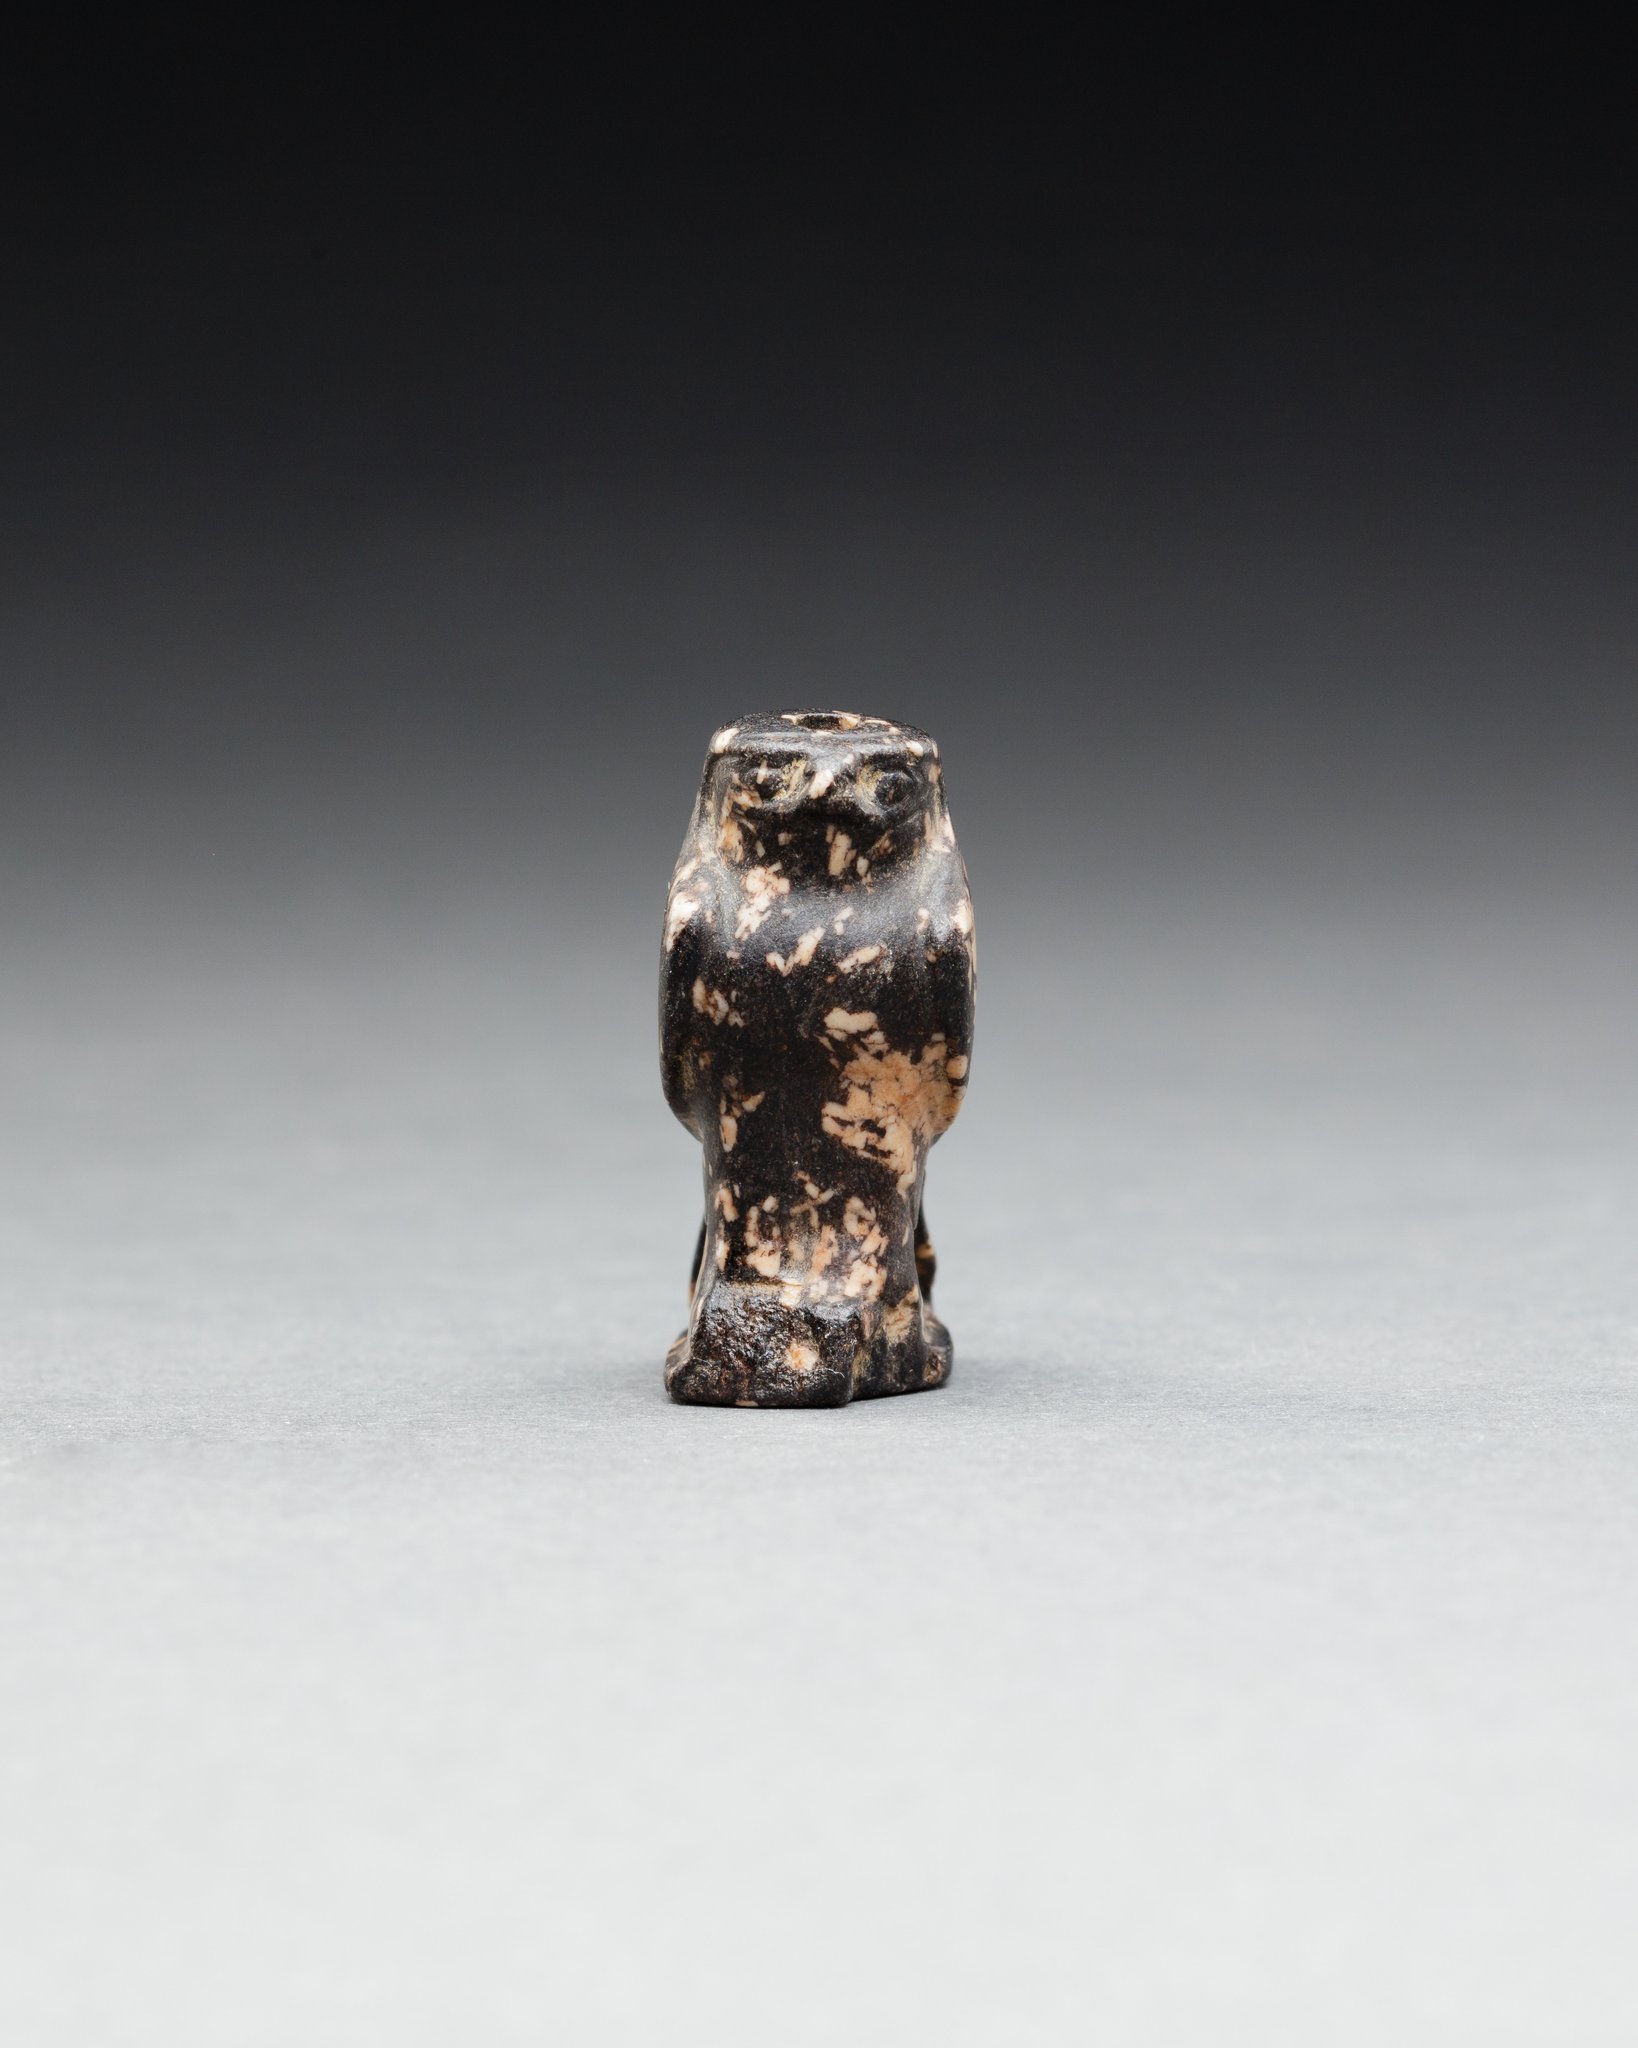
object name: amulet, falcon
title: Falcon Amulet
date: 664-630 BCE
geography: egypt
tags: falcons